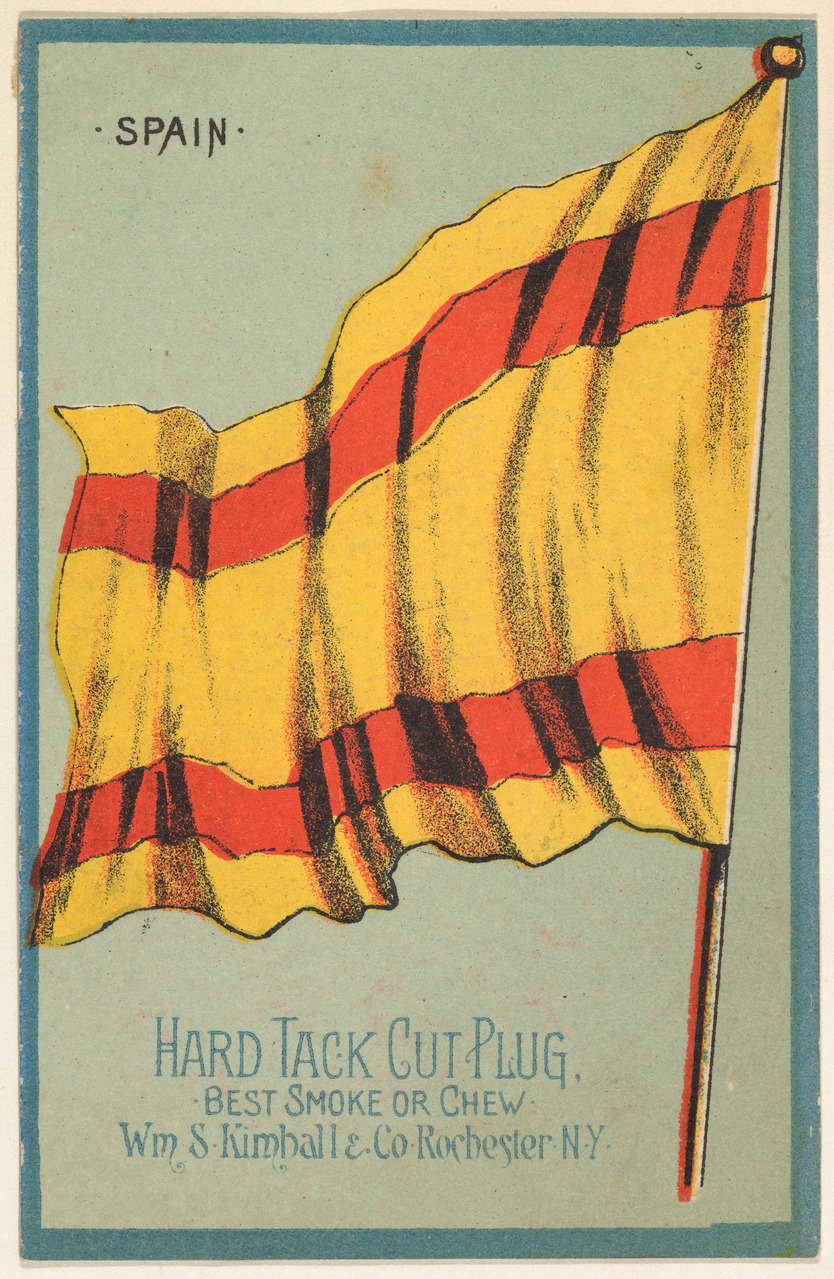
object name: print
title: Spain, from the National Flags series (N195) issued by Wm. S. Kimball & Co.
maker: william s. kimball & company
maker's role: publisher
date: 1891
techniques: color lithograph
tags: flags